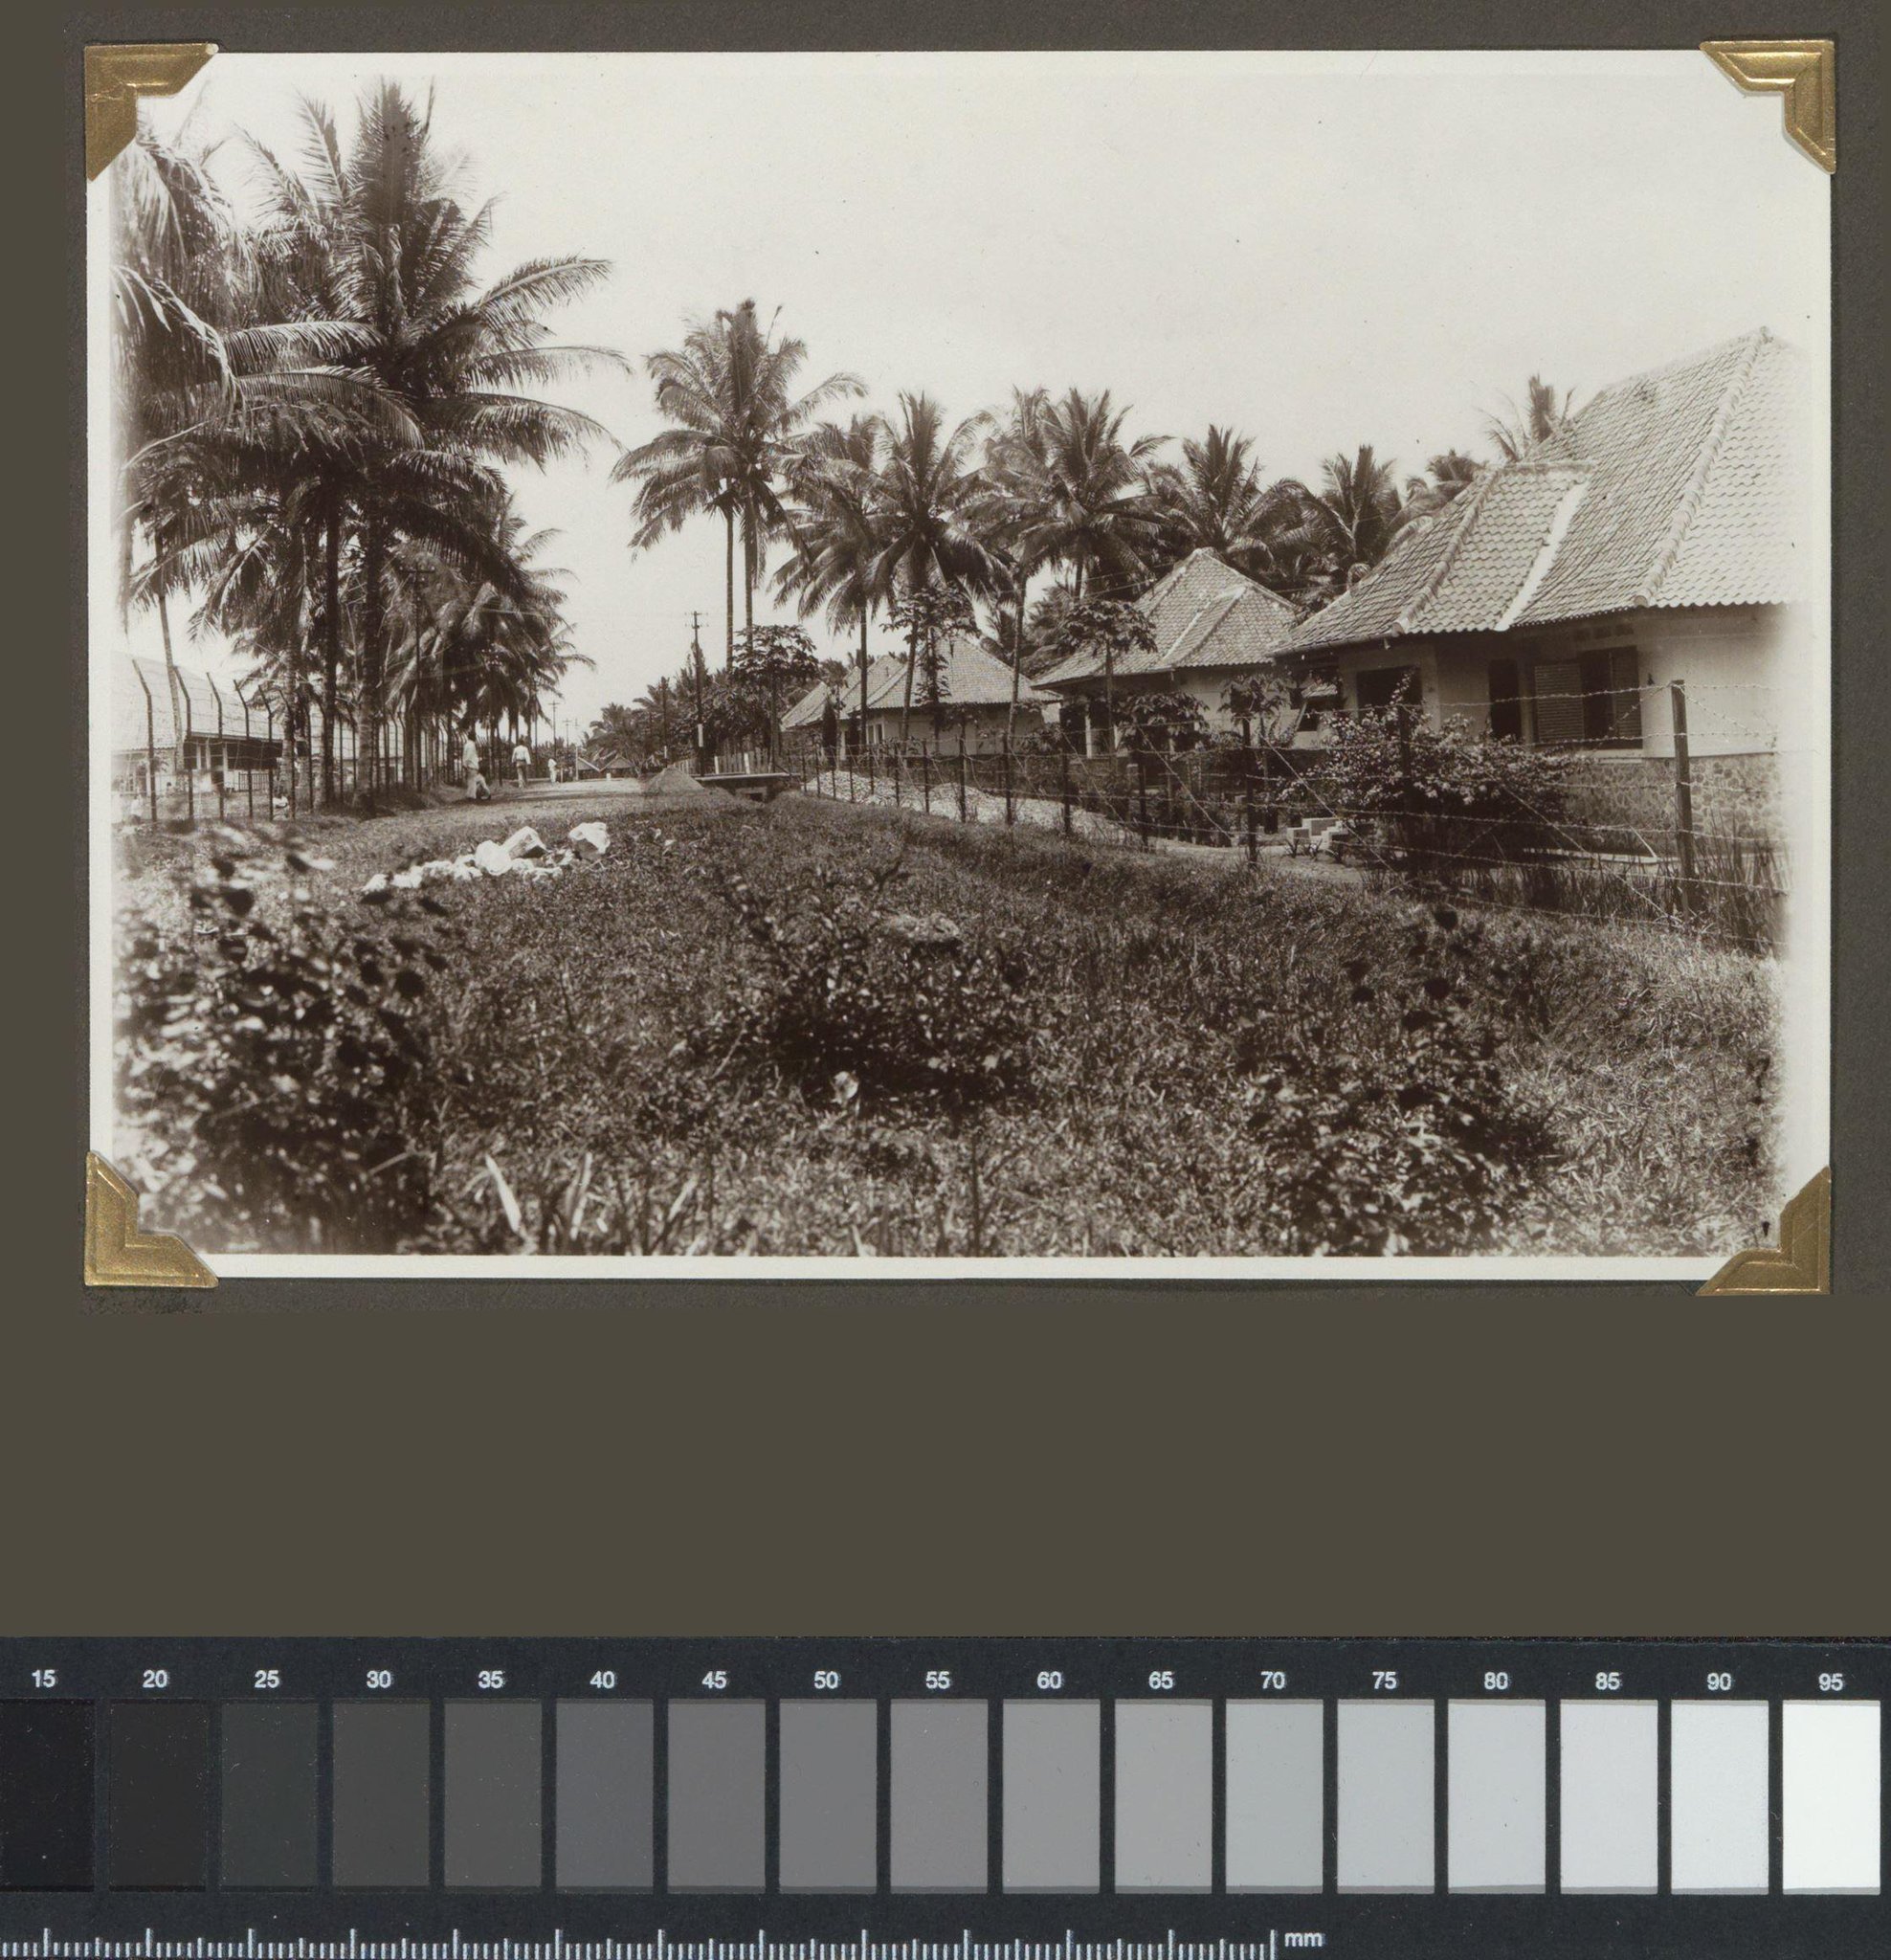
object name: photograph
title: Complex met kaderwoningen van de politie in Lampong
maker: Anonymous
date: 1932-1933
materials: photographic support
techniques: gelatin silver print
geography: lampung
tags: rural housing, e.g. country-house, villa, cottage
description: Onderdeel van Herinneringsalbum voor F.J. Junius, vertrekkend resident van Lampong (Zuid-Sumatra).